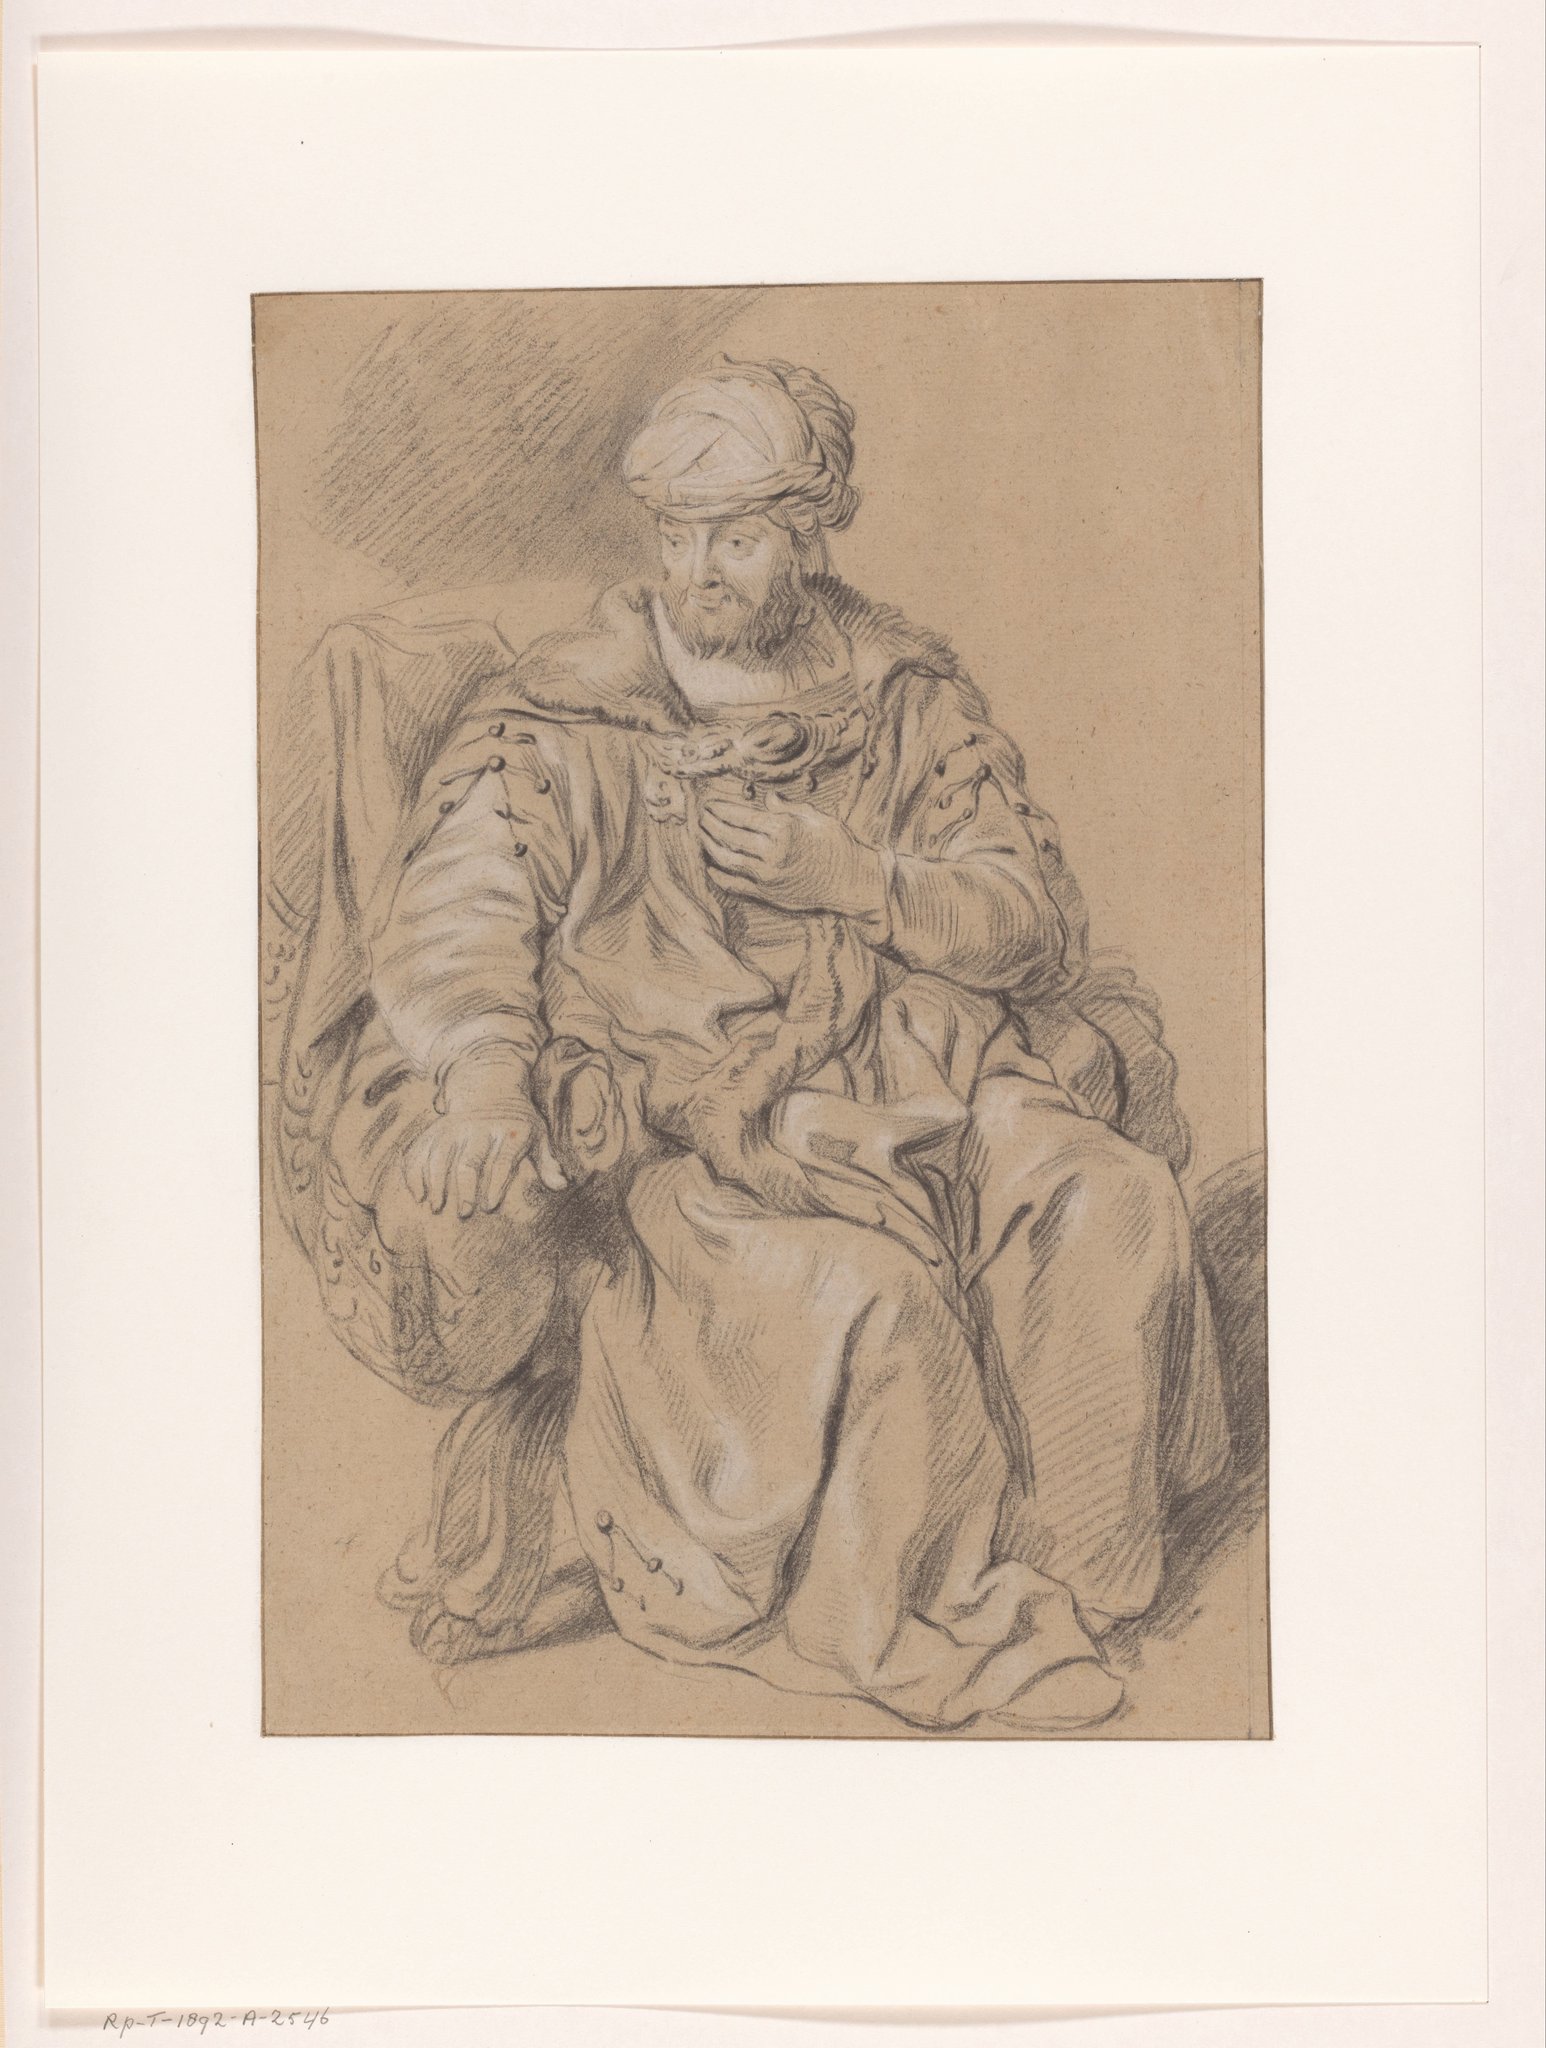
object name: drawing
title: Seated Oriental man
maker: Anonymous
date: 1631-1674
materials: chalk, graphite, ink, paper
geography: amsterdam